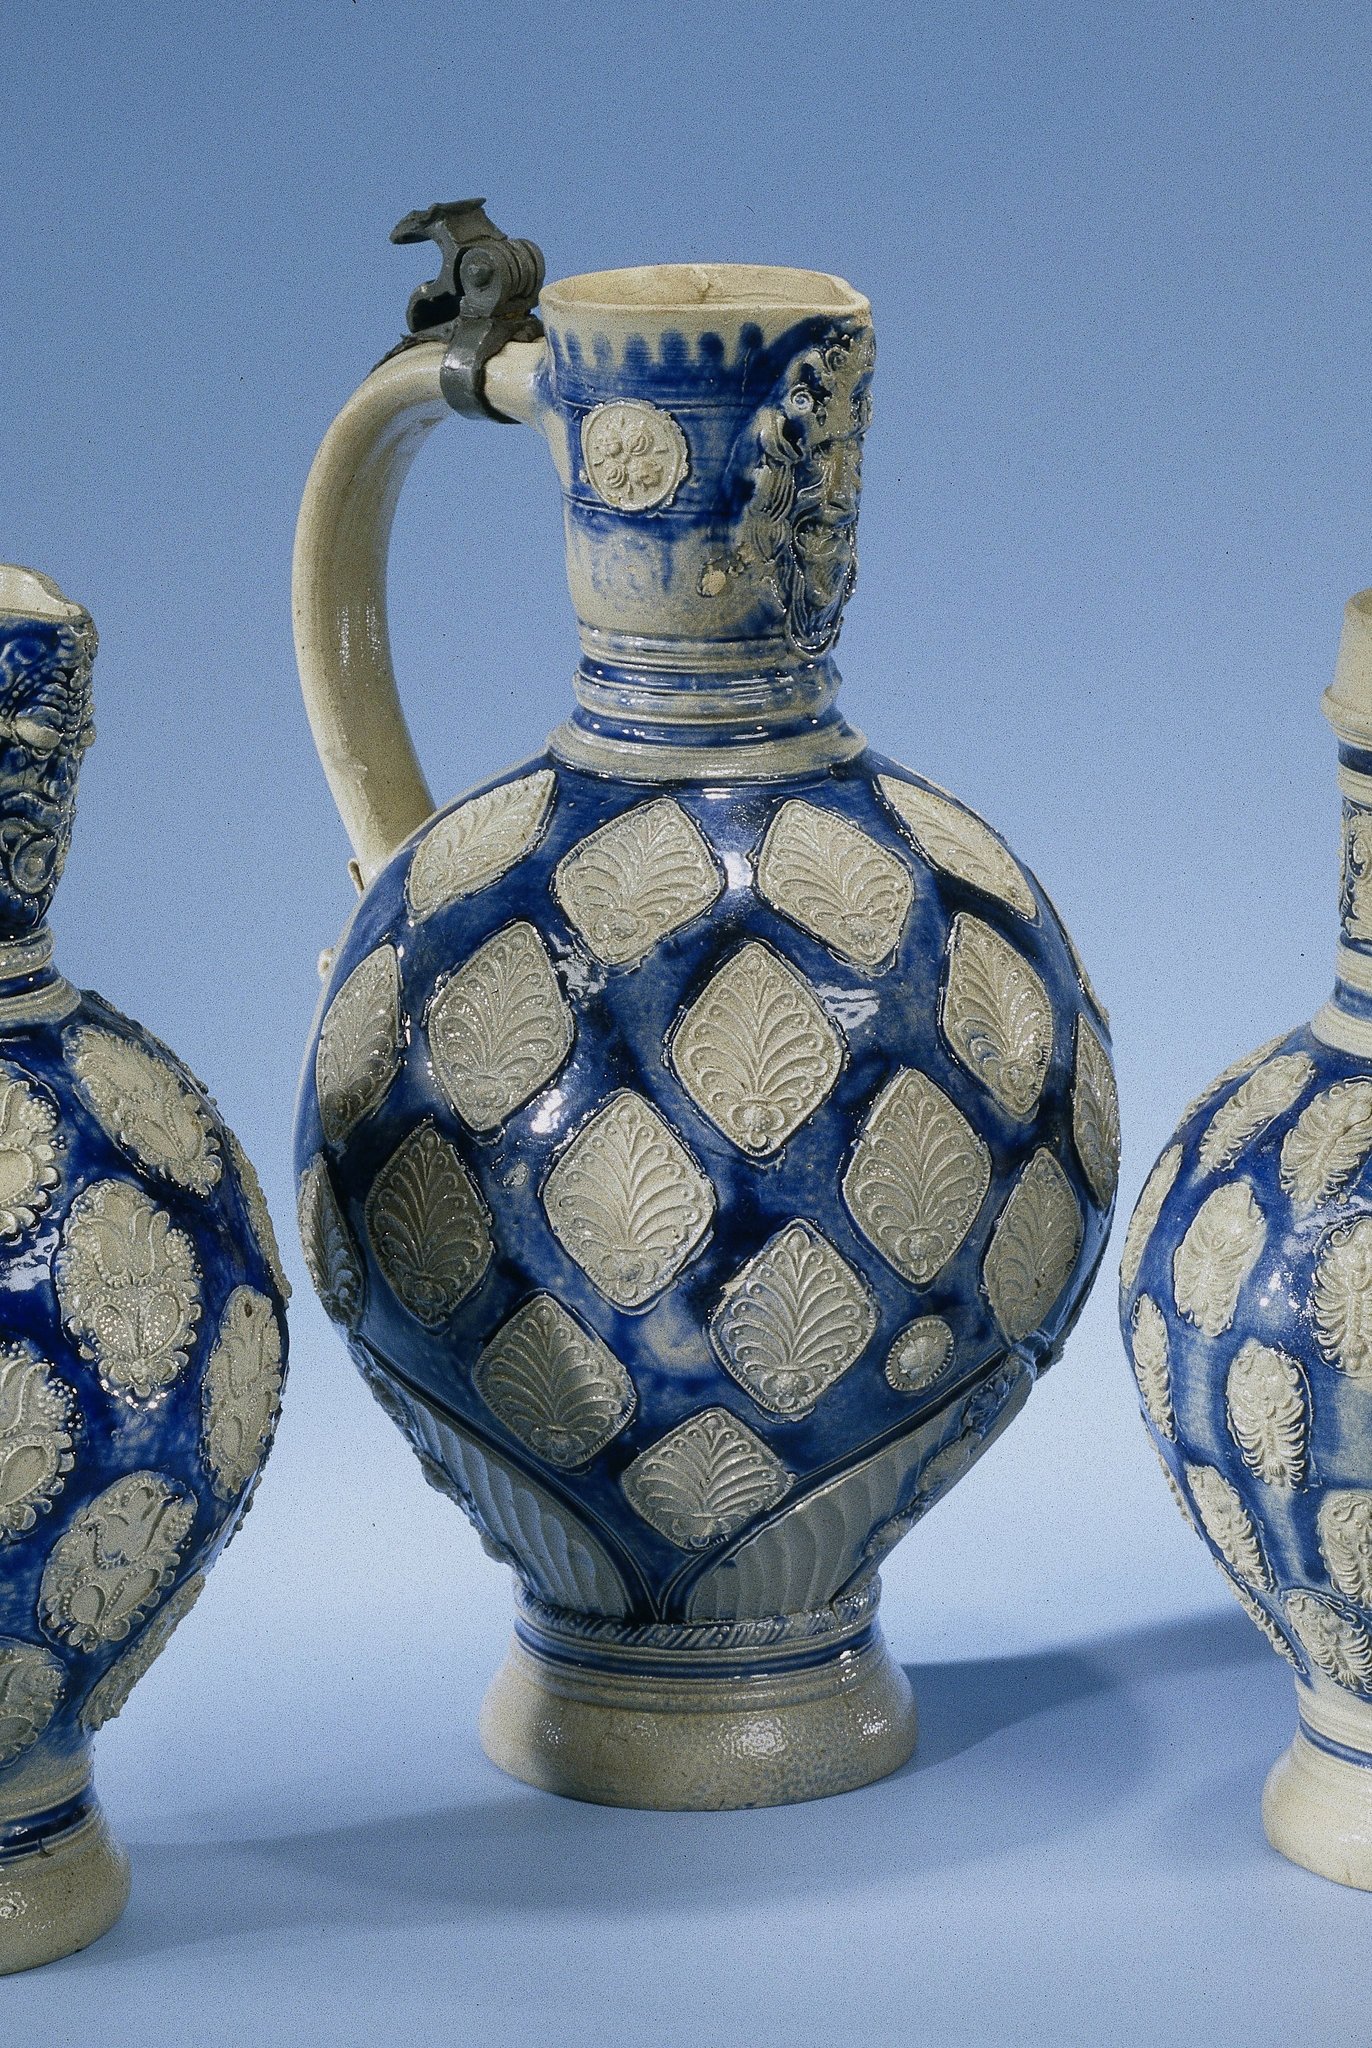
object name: ewer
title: Jug with a lion's head and medallions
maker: Anonymous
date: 1650-1699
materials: cobalt, glaze, stoneware, tin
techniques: firing, forming, relief, turning, vitrification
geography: westerwald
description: Kruik van steengoed op hoge voet met een eivormig lichaam en een smalle nek met geknepen tuit. Het C-vormige oor is bevestigd aan de nek en de buik. Profielen op de nek en voet. Gedeeltelijk bedekt met kobaltblauw. Op de buik in reliëf vijf rijen met gedrukte en opgelegde medaillons met een gestileerd bladmotief, uitgespaard in blauw. Boven de voet drie grote, ingegrifte bladeren met in elk drie medaillons met rozetten. Op de nek een gemodelleerde leeuwenkop met aan weerszijden een medaillon. Bevestigd aan het oor een montuur; deksel ontbreekt. Westerwald.